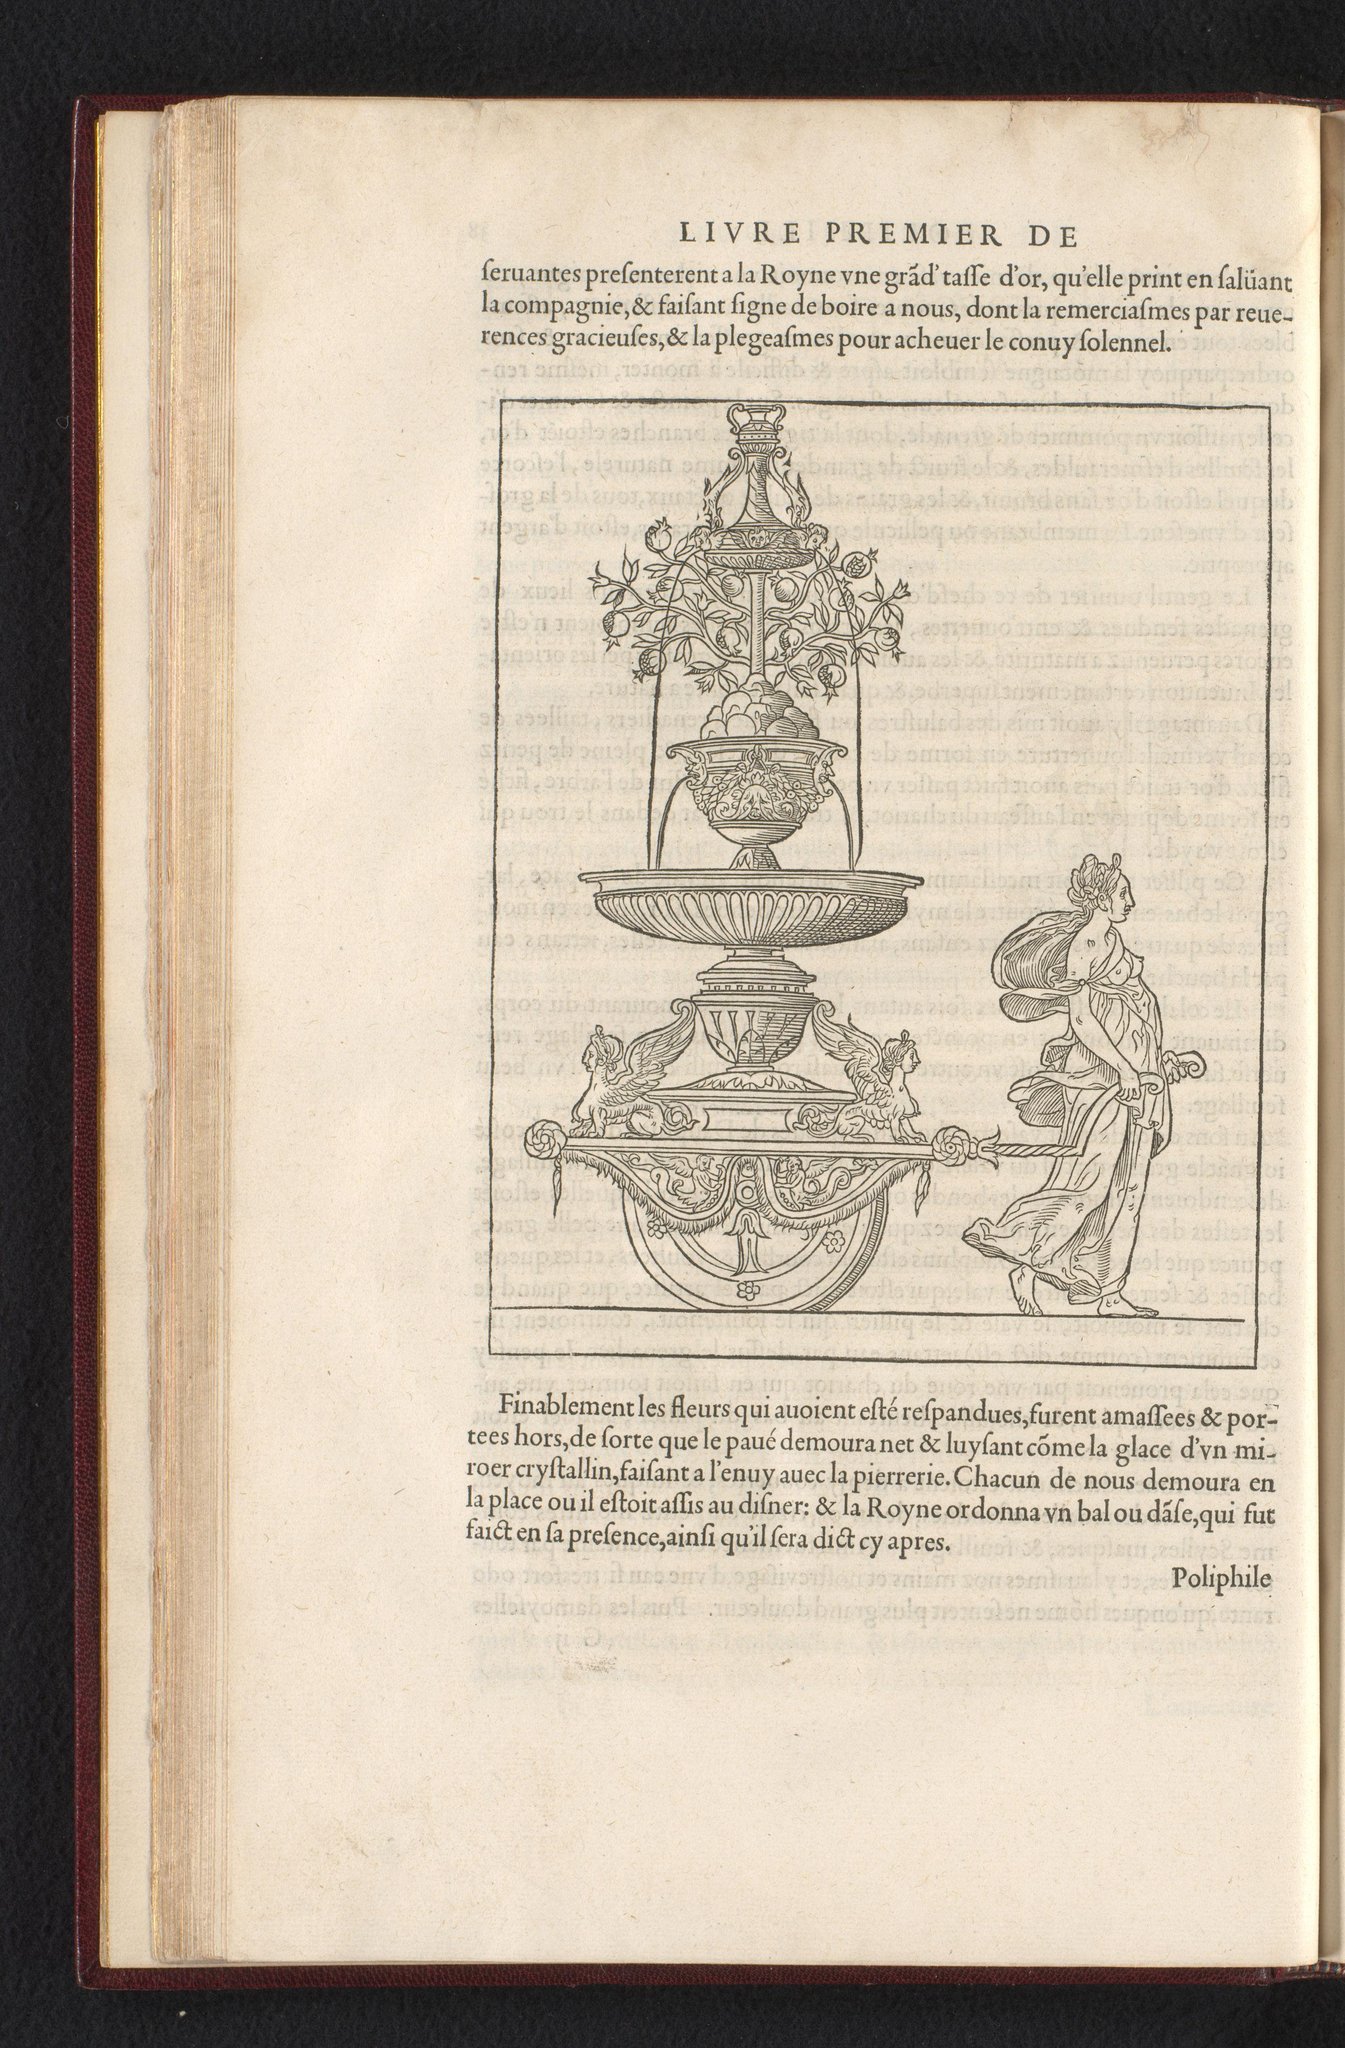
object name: book illustration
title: Decoratieve fontein op een wiel, getrokken door een vrouw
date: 1546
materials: paper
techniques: letterpress printing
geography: paris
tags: (scenes from) specific works of literature: colonna, hypnerotomachia poliphili, fountain (indoors)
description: Prent uit: Colonna, Francesco. Hypnerotomachie ou discours du songe de Poliphile, deduisant comme amour le combat a l'occasion de Polia. Parijs: Jacques Kerver, 1546, verso fol. 38.